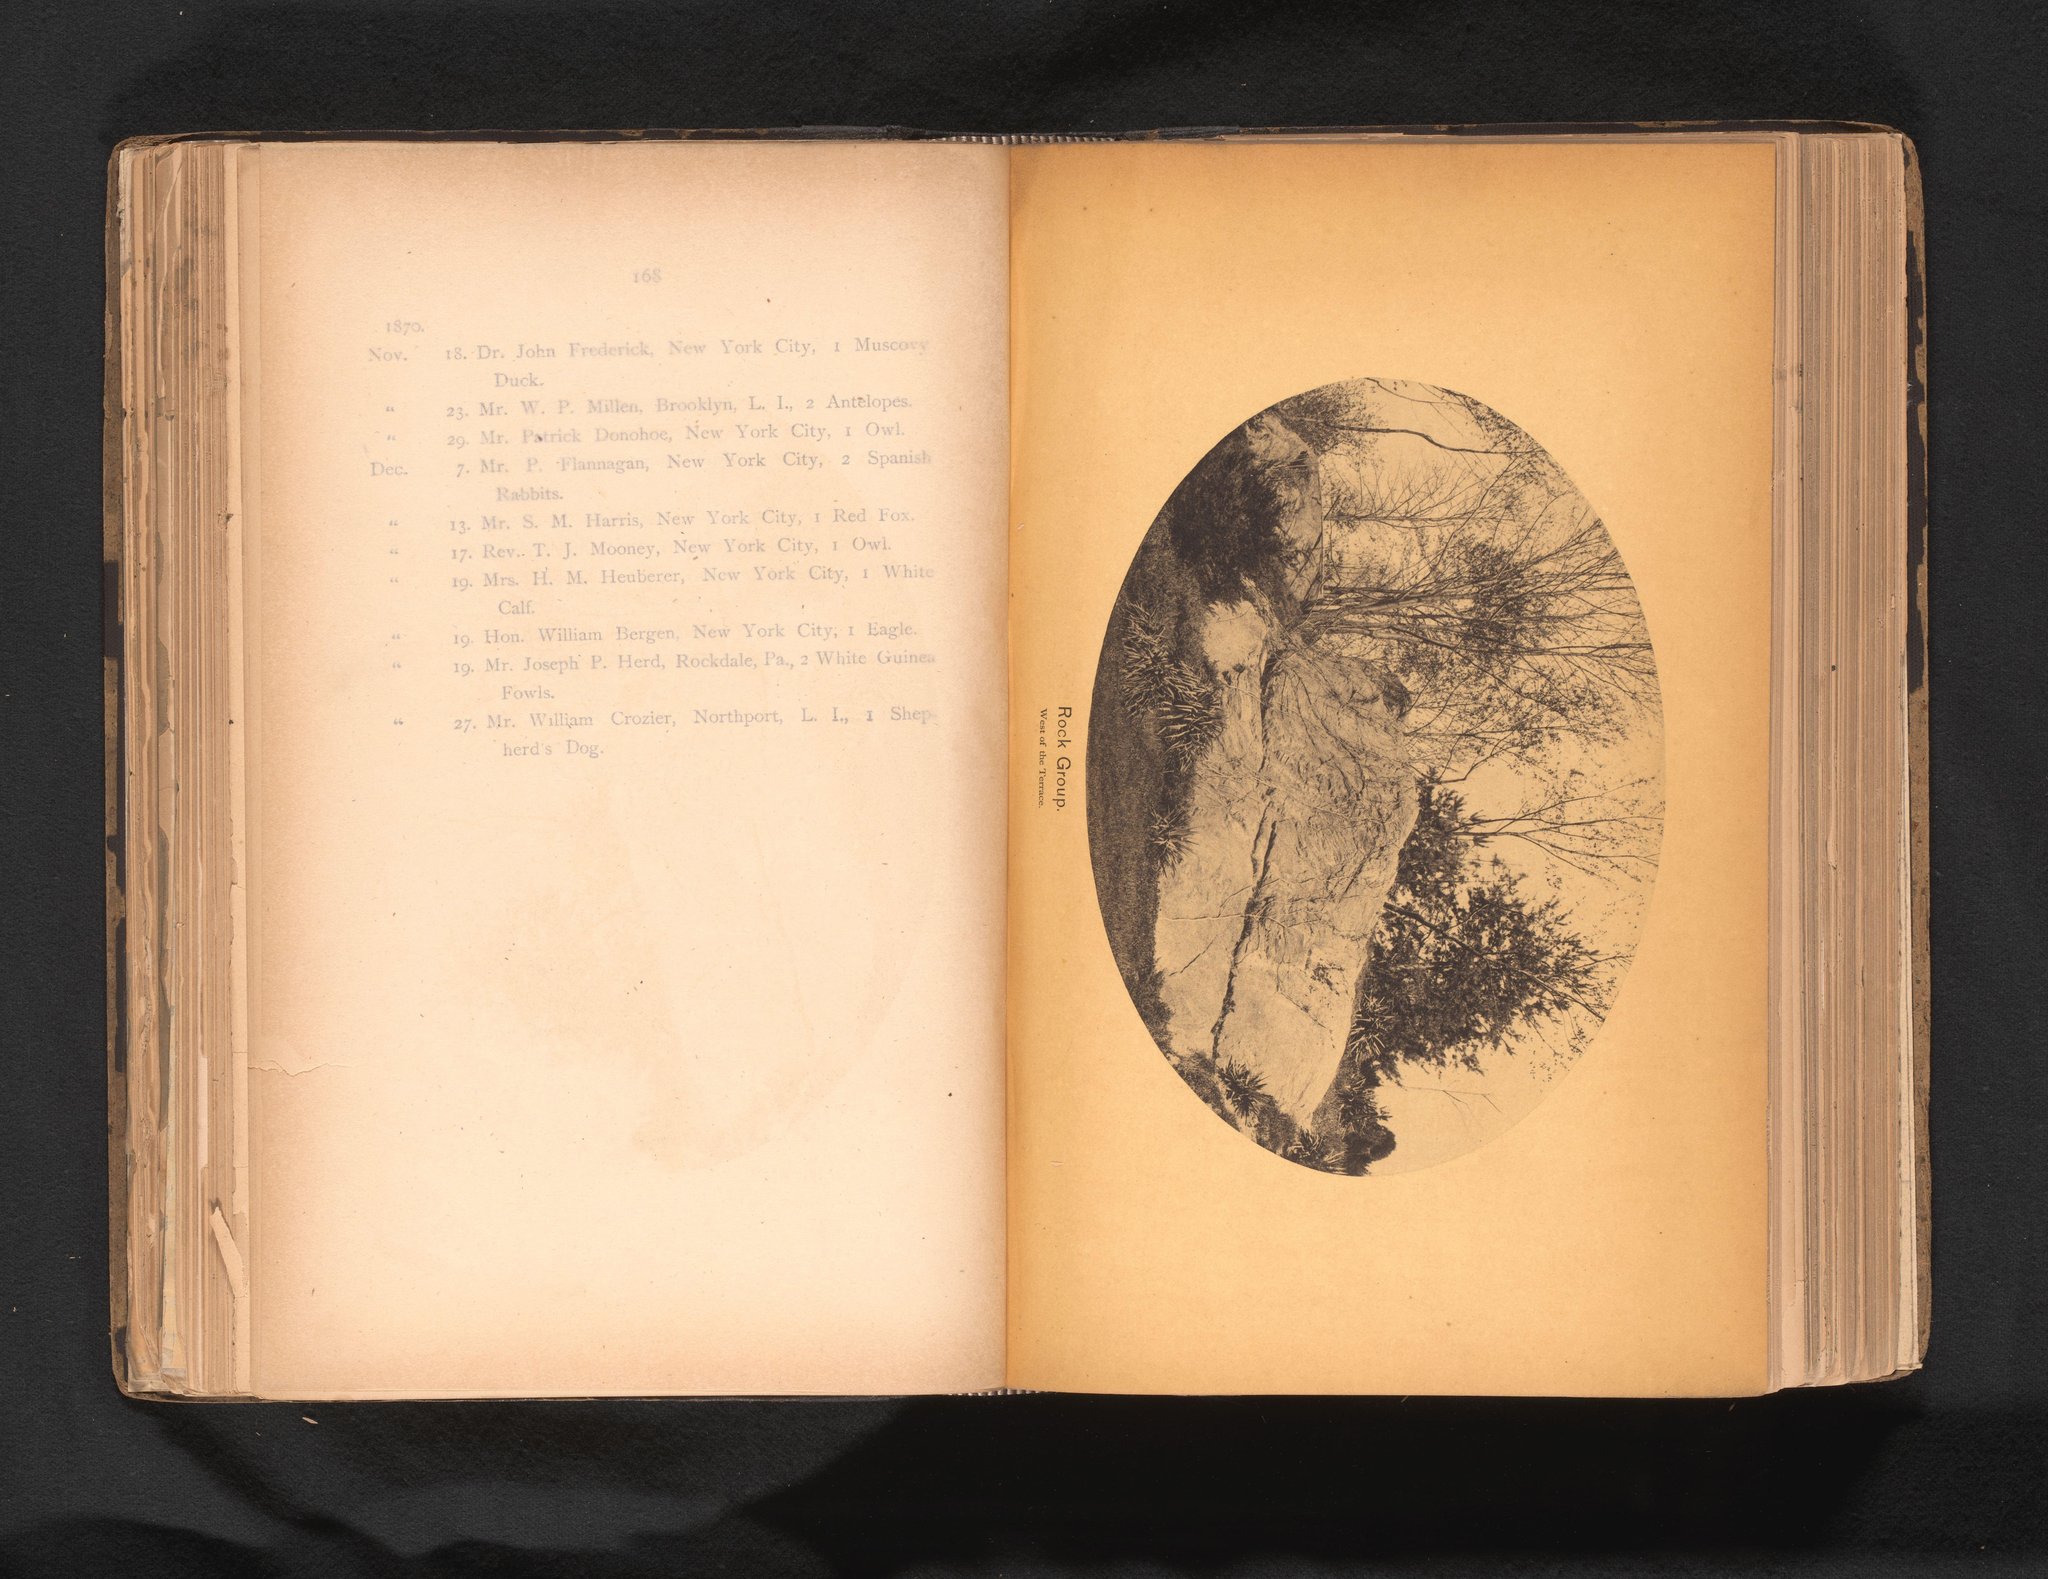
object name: page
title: Rock group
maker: Anonymous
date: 1866-1871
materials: paper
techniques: photograph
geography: central park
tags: rock-formations